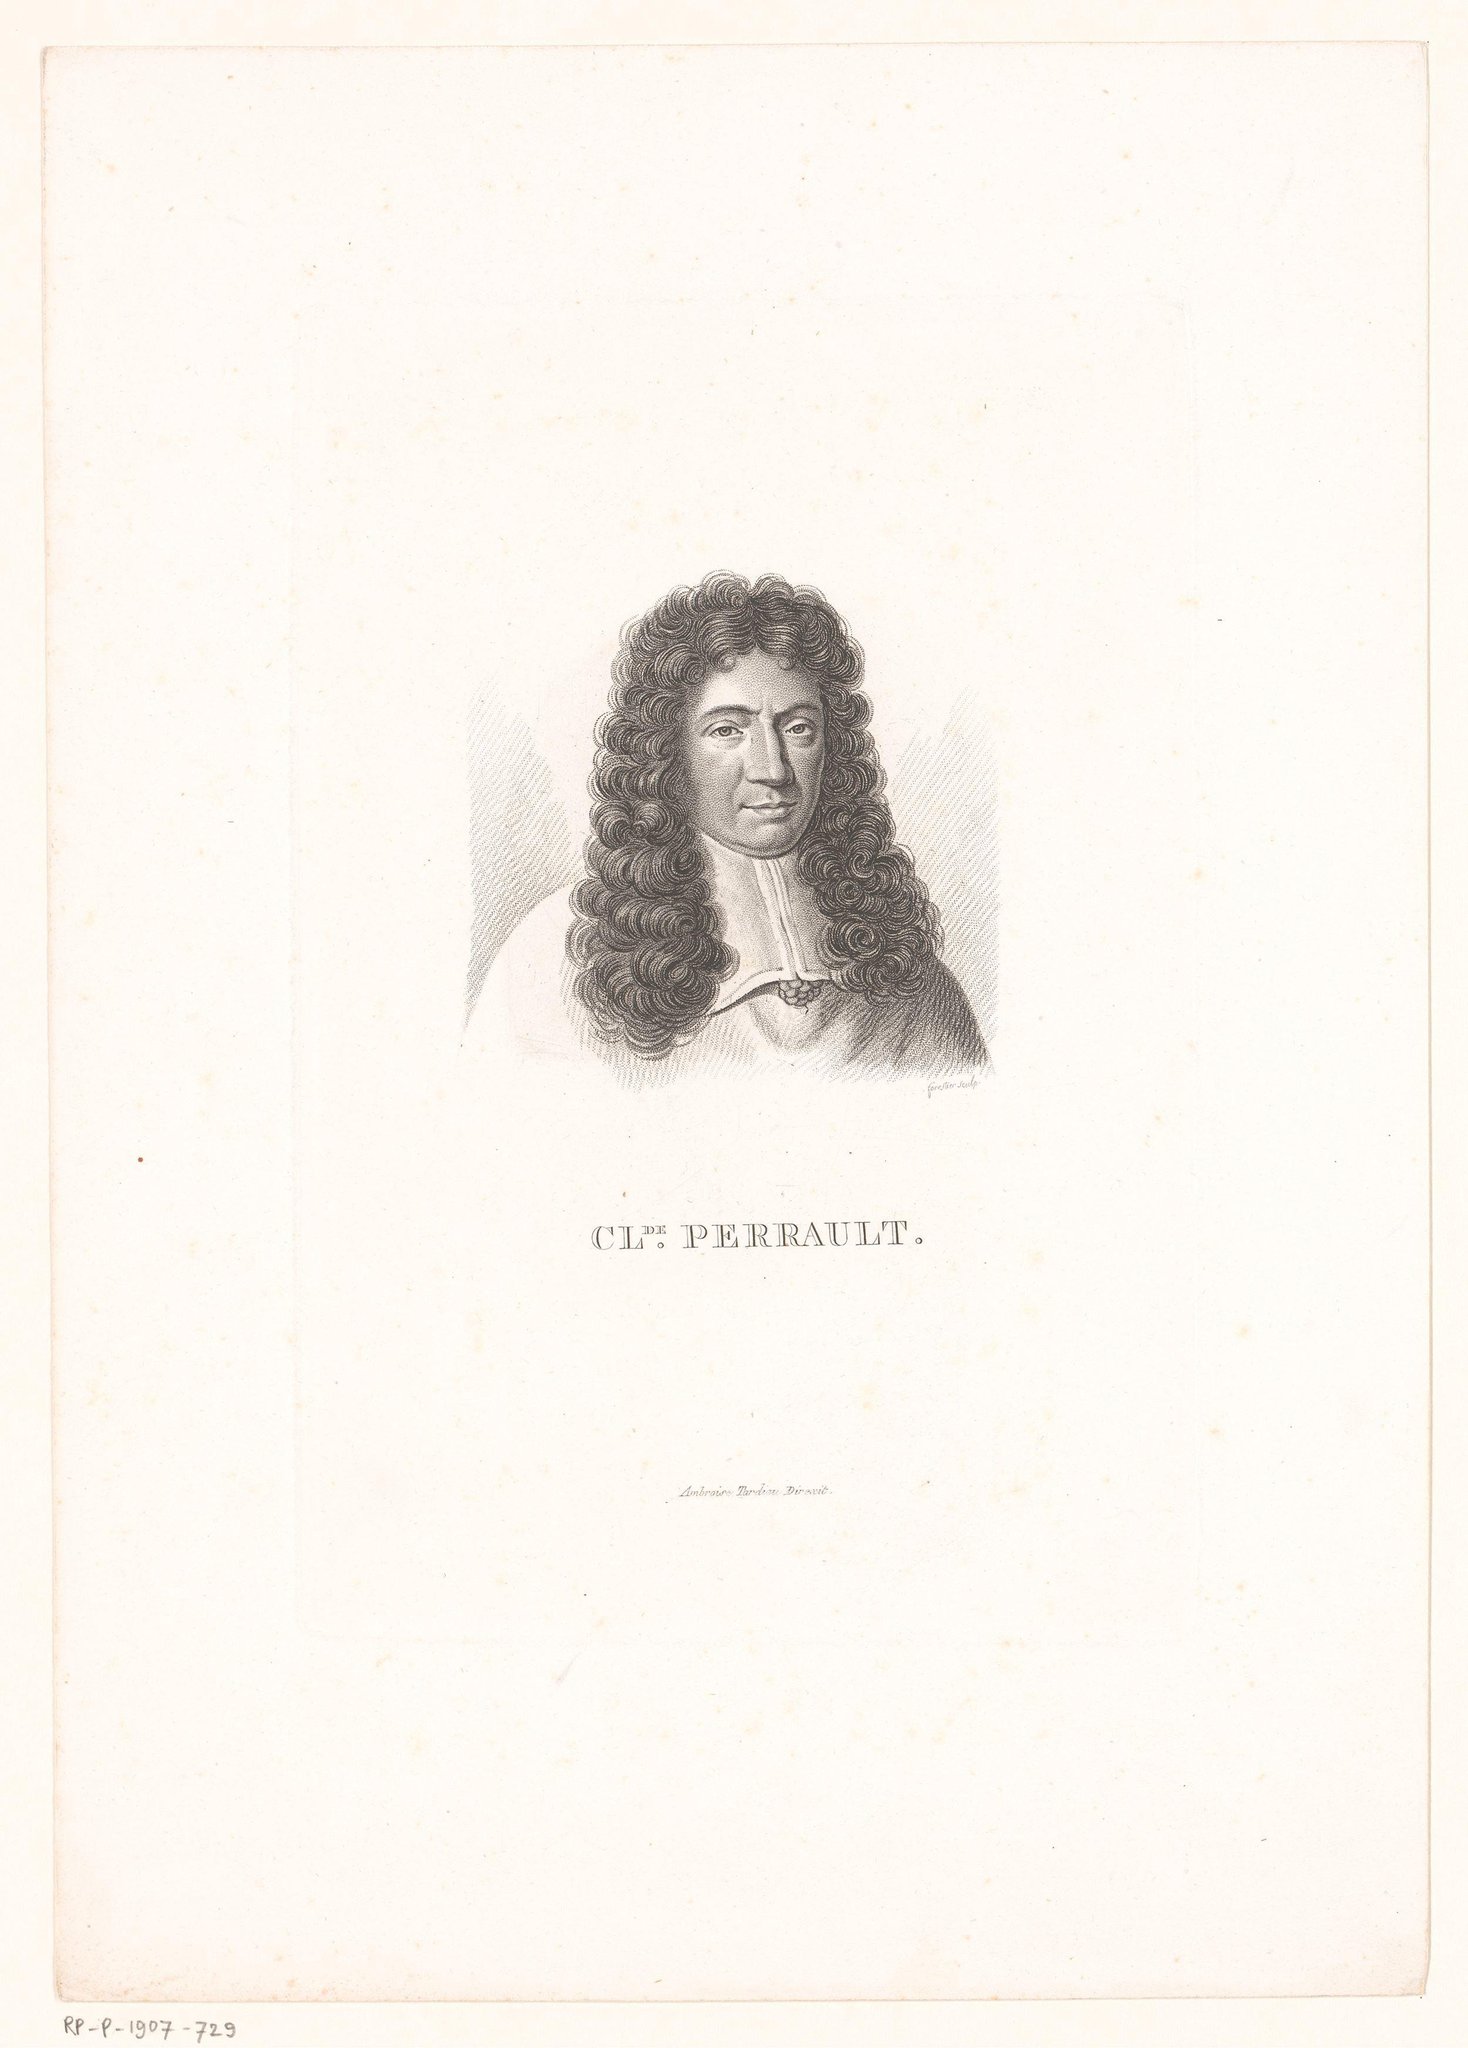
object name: book illustration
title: Portret van Claude Perrault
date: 1818-1832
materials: paper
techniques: engraving, roulette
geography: paris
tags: paris, claude perrault, historical persons, physician, doctor, portrait, self-portrait of artist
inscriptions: collector's mark: Lugt 2228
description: Mogelijk prent uit: Journal complémentaire du Dictionnaire des sciences médicales. Parijs: Panckoucke, Charles Louis Fleury, 1818-1832.